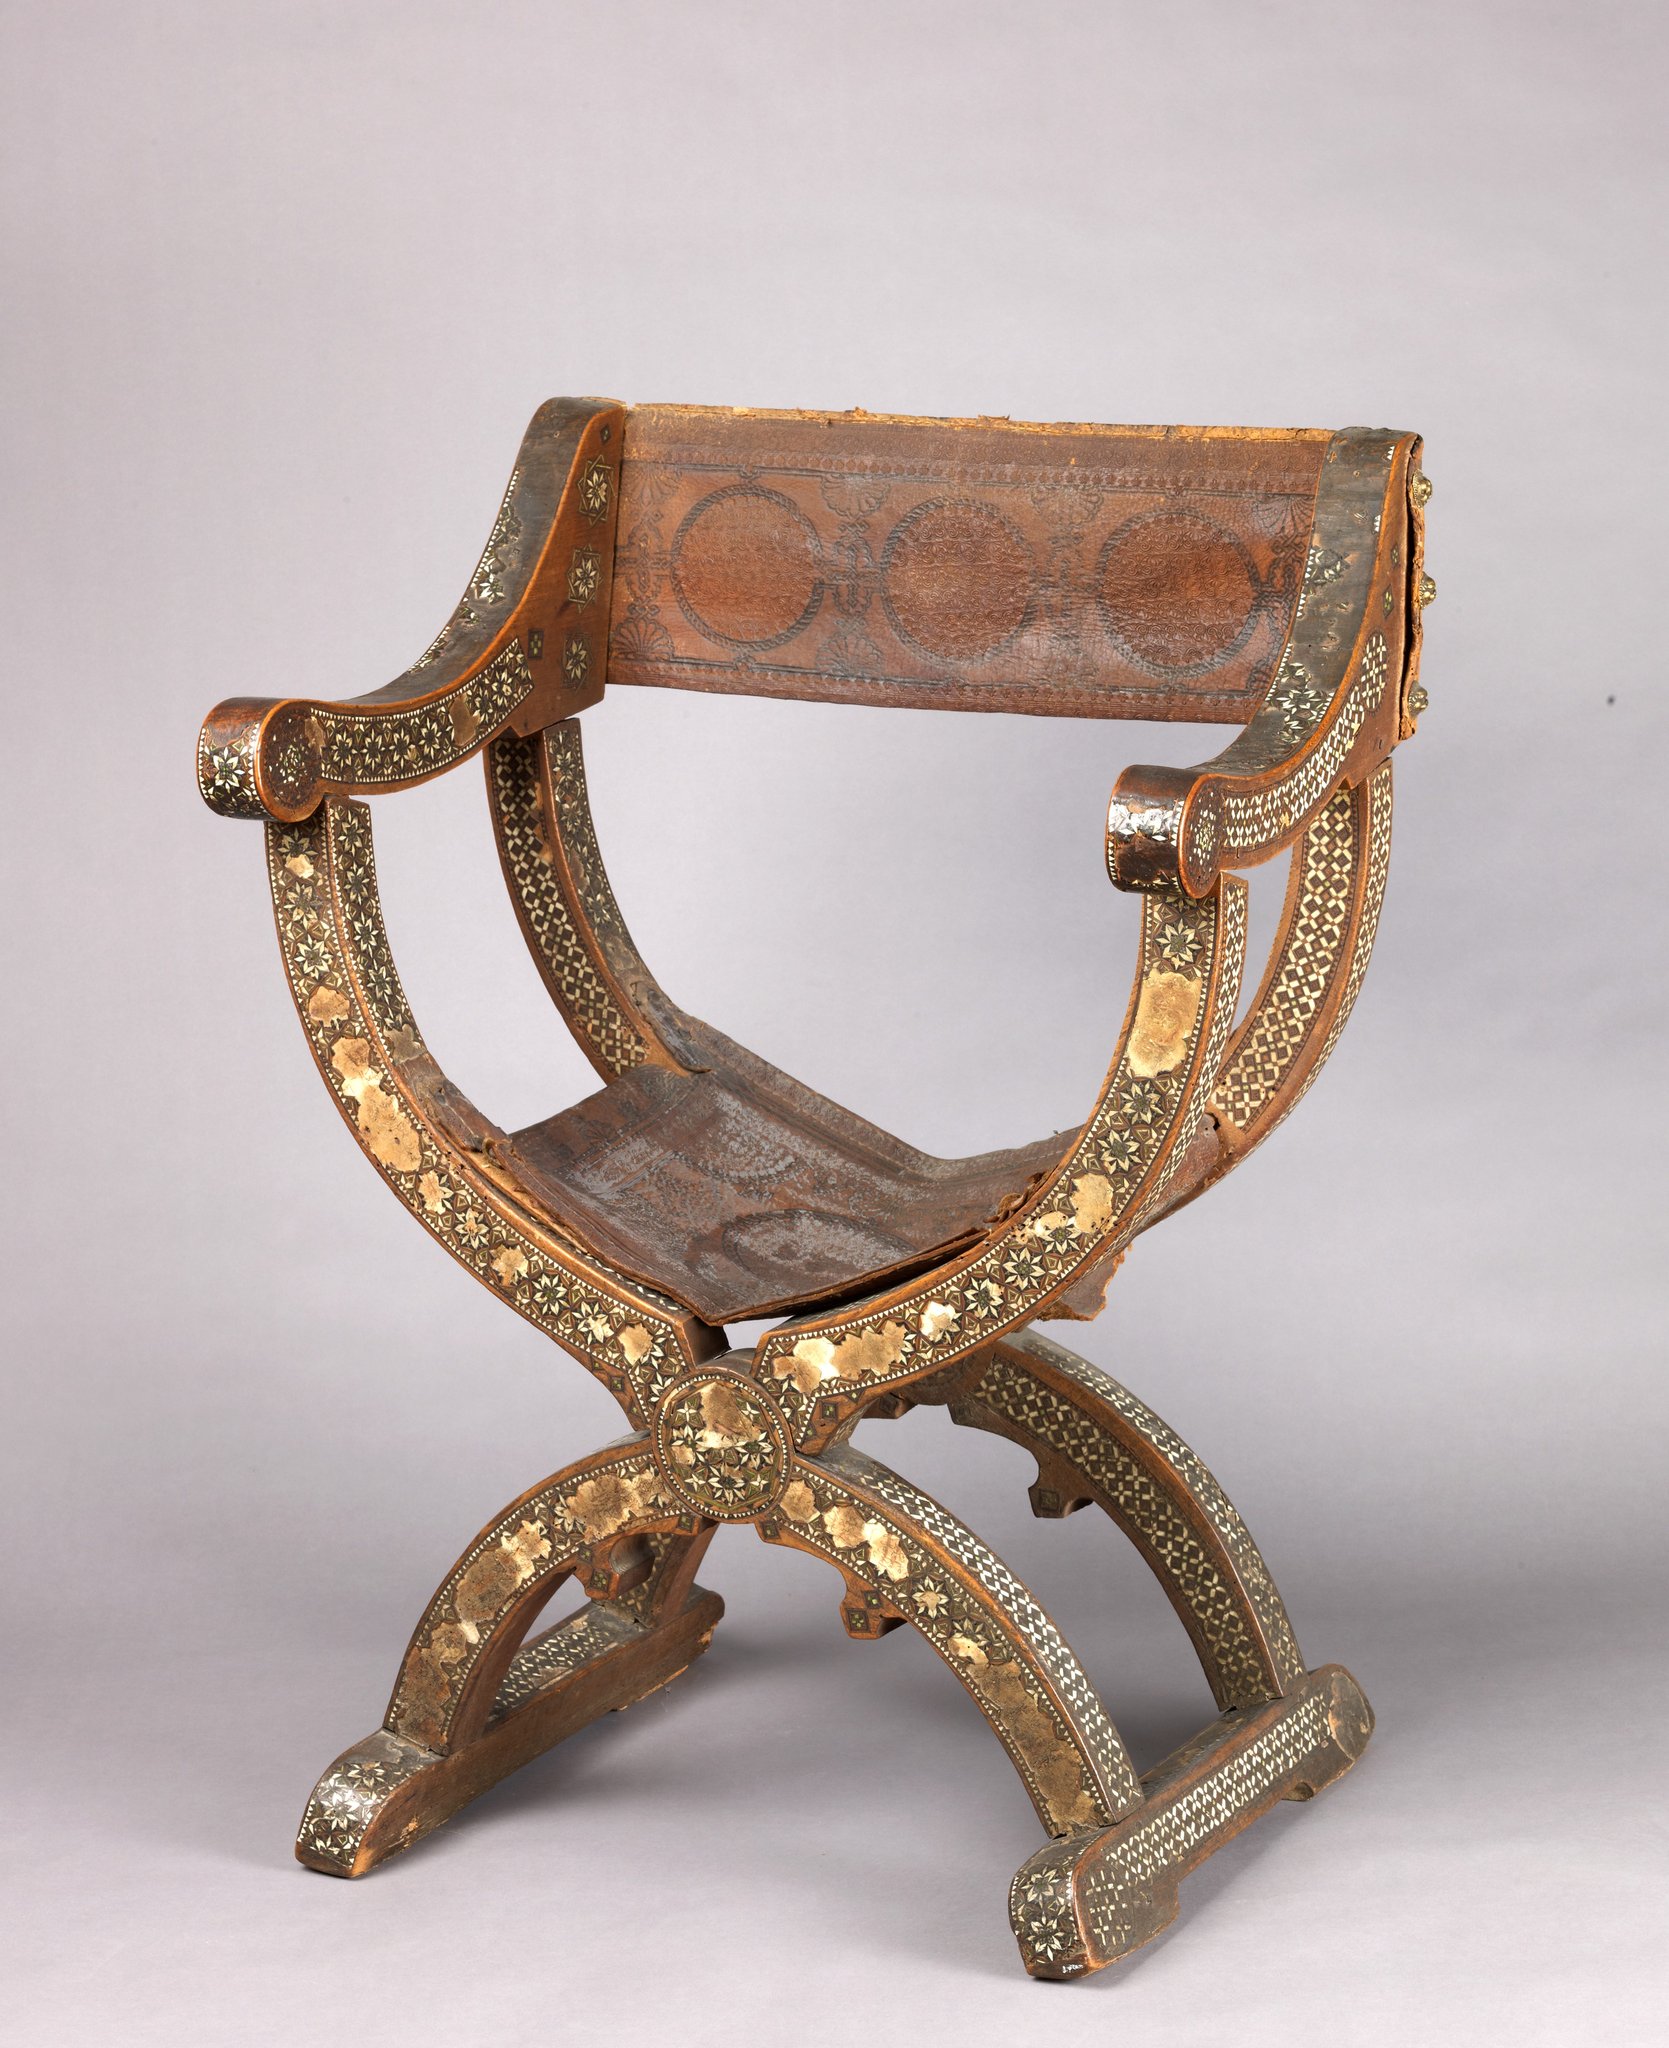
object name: armchair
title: Hip-joint armchair (sillón de cadera or jamuga)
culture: spanish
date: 1480-1489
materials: wood, ivory, leather, mother of pearl, parchment, pewter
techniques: tooling